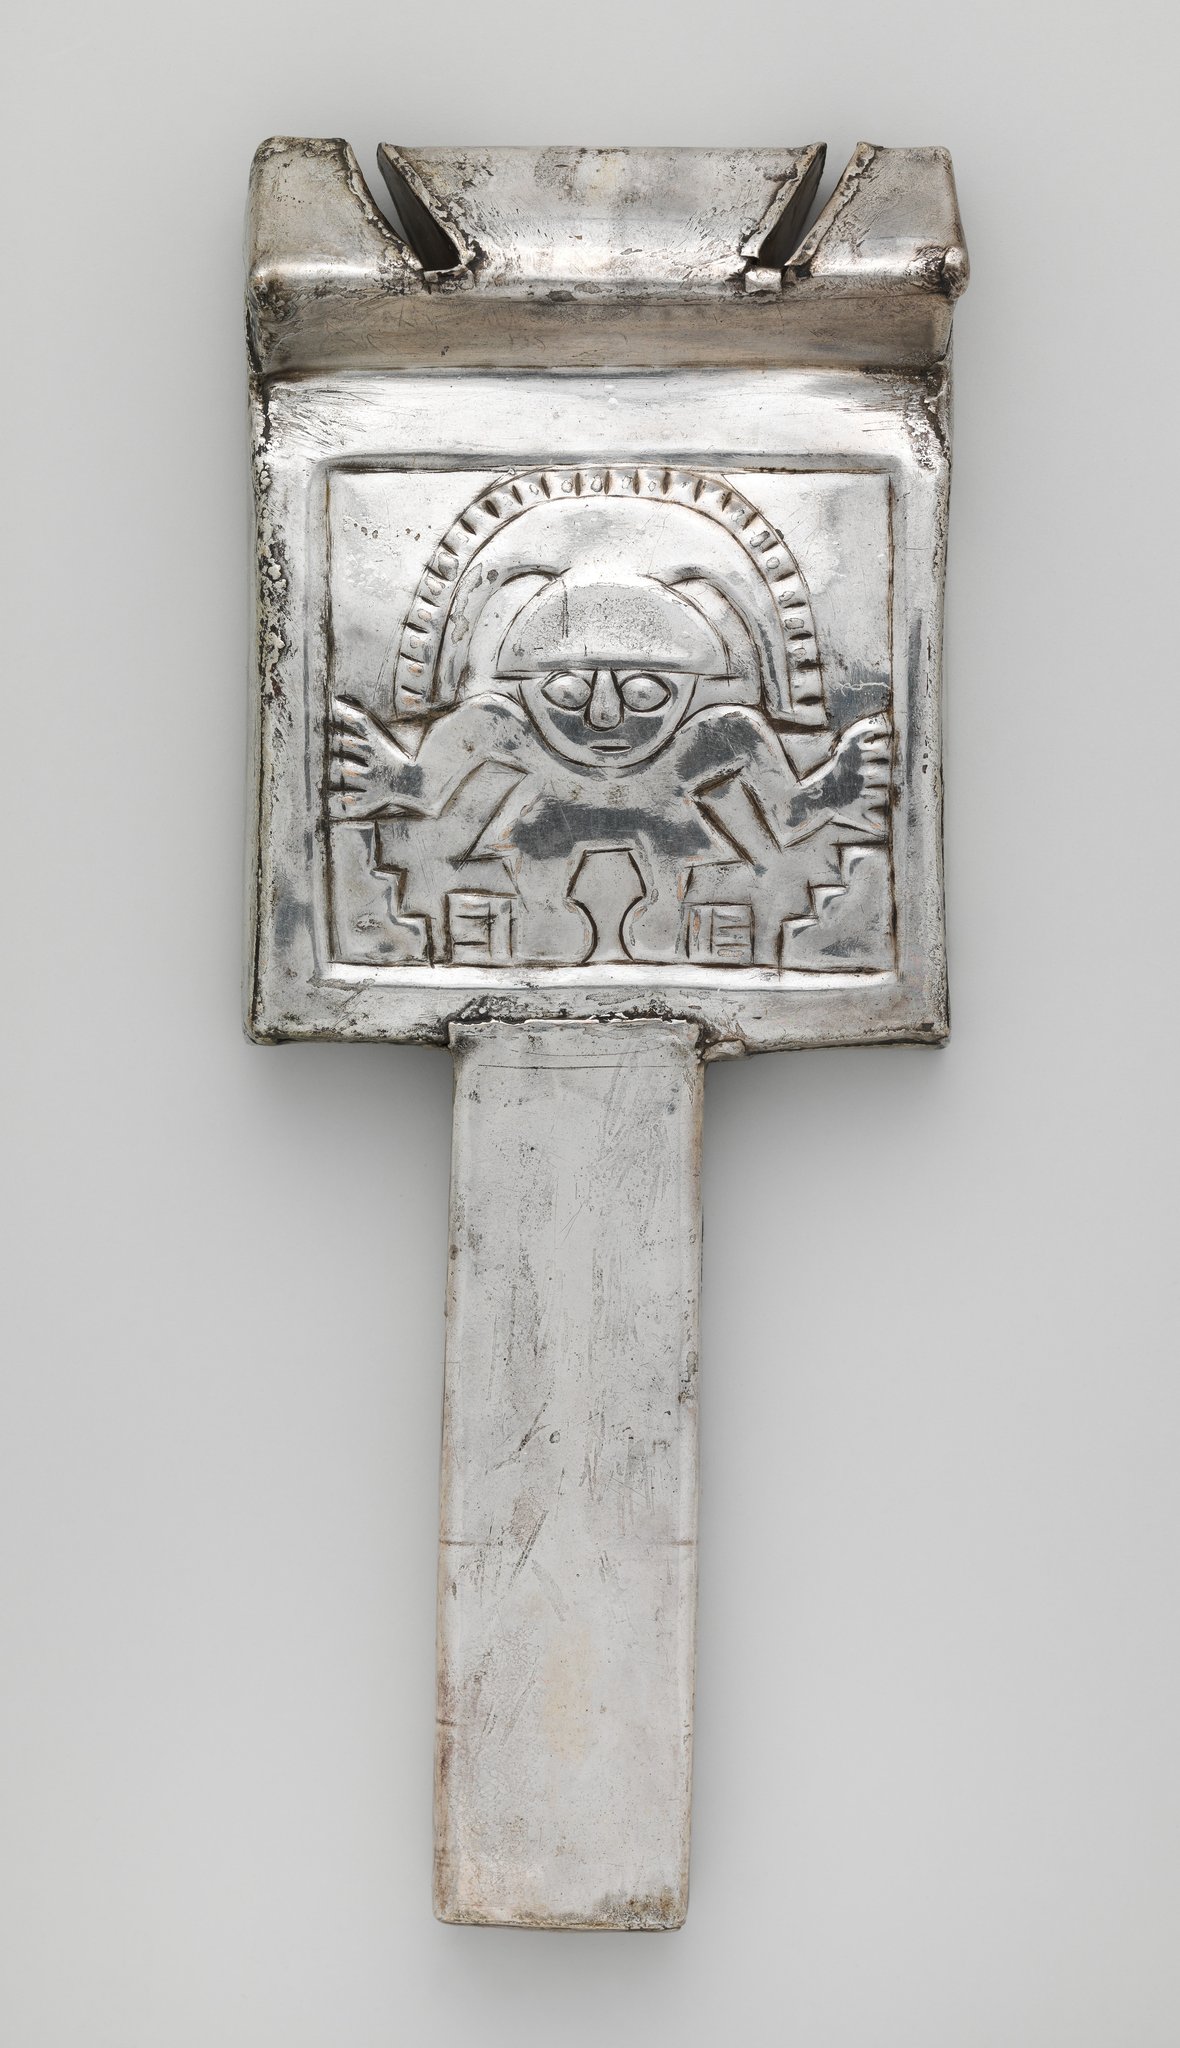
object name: mirror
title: Miniature mirror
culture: chancay or chimú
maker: chimú or chancay artist(s)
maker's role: artist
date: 1300-1470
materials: silver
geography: peru